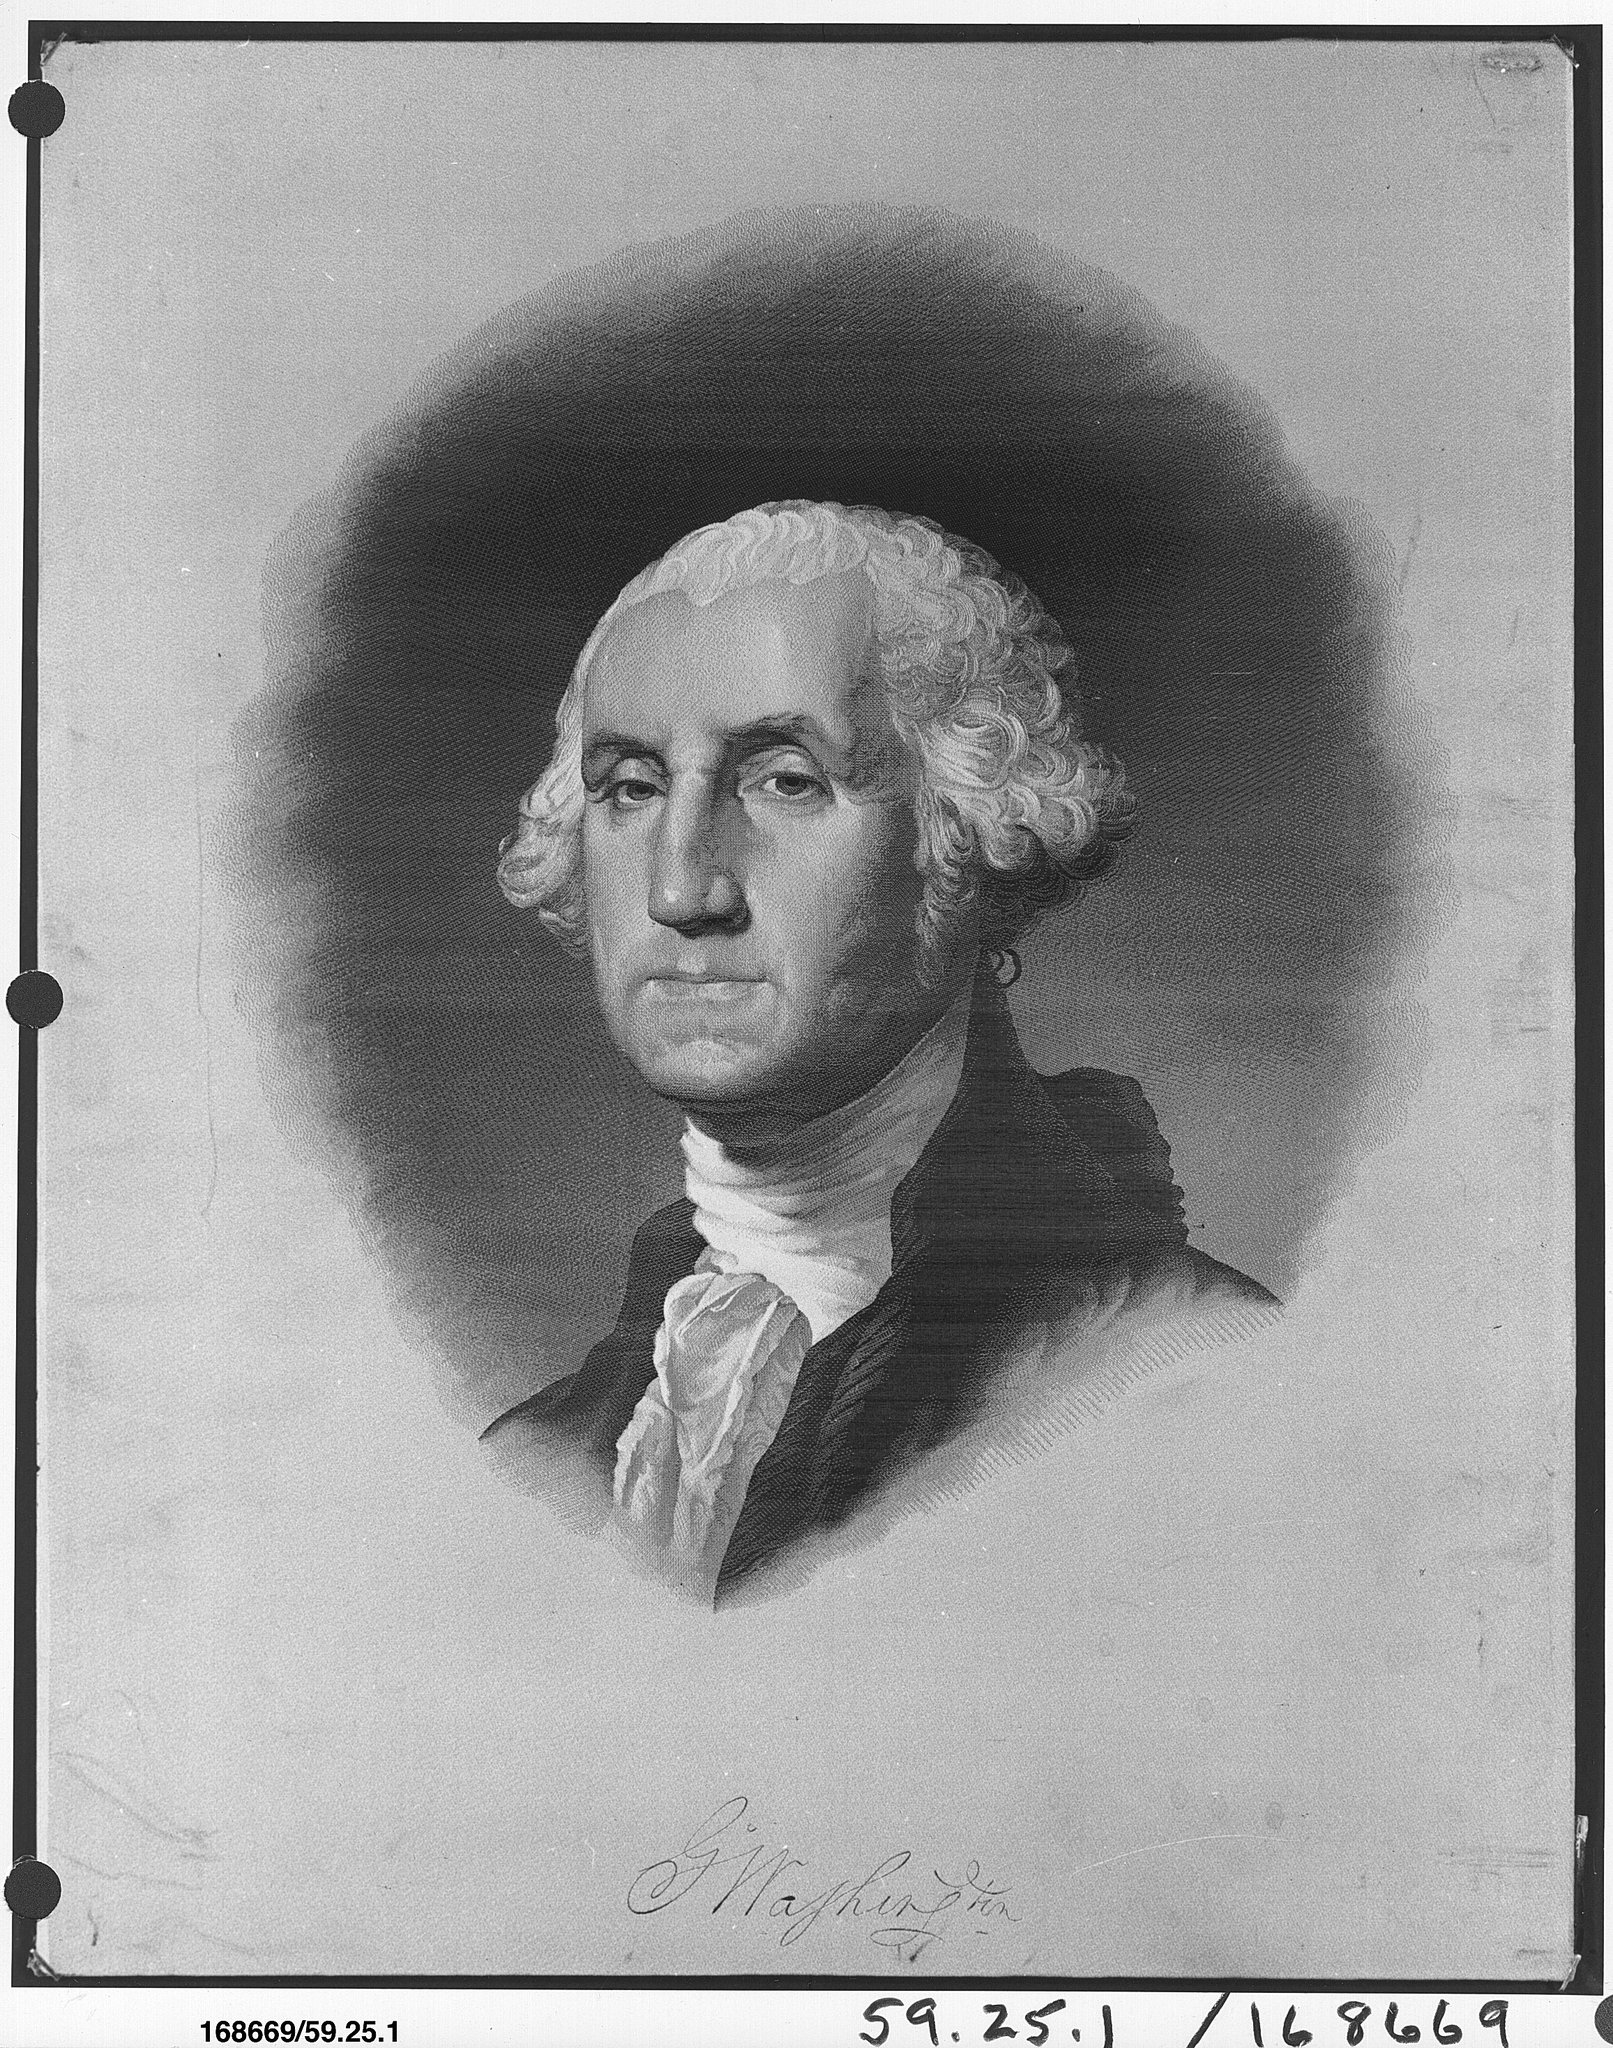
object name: portrait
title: President George Washington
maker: mathevon et bouvard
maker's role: manufactory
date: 1893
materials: silk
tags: george washington,portraits